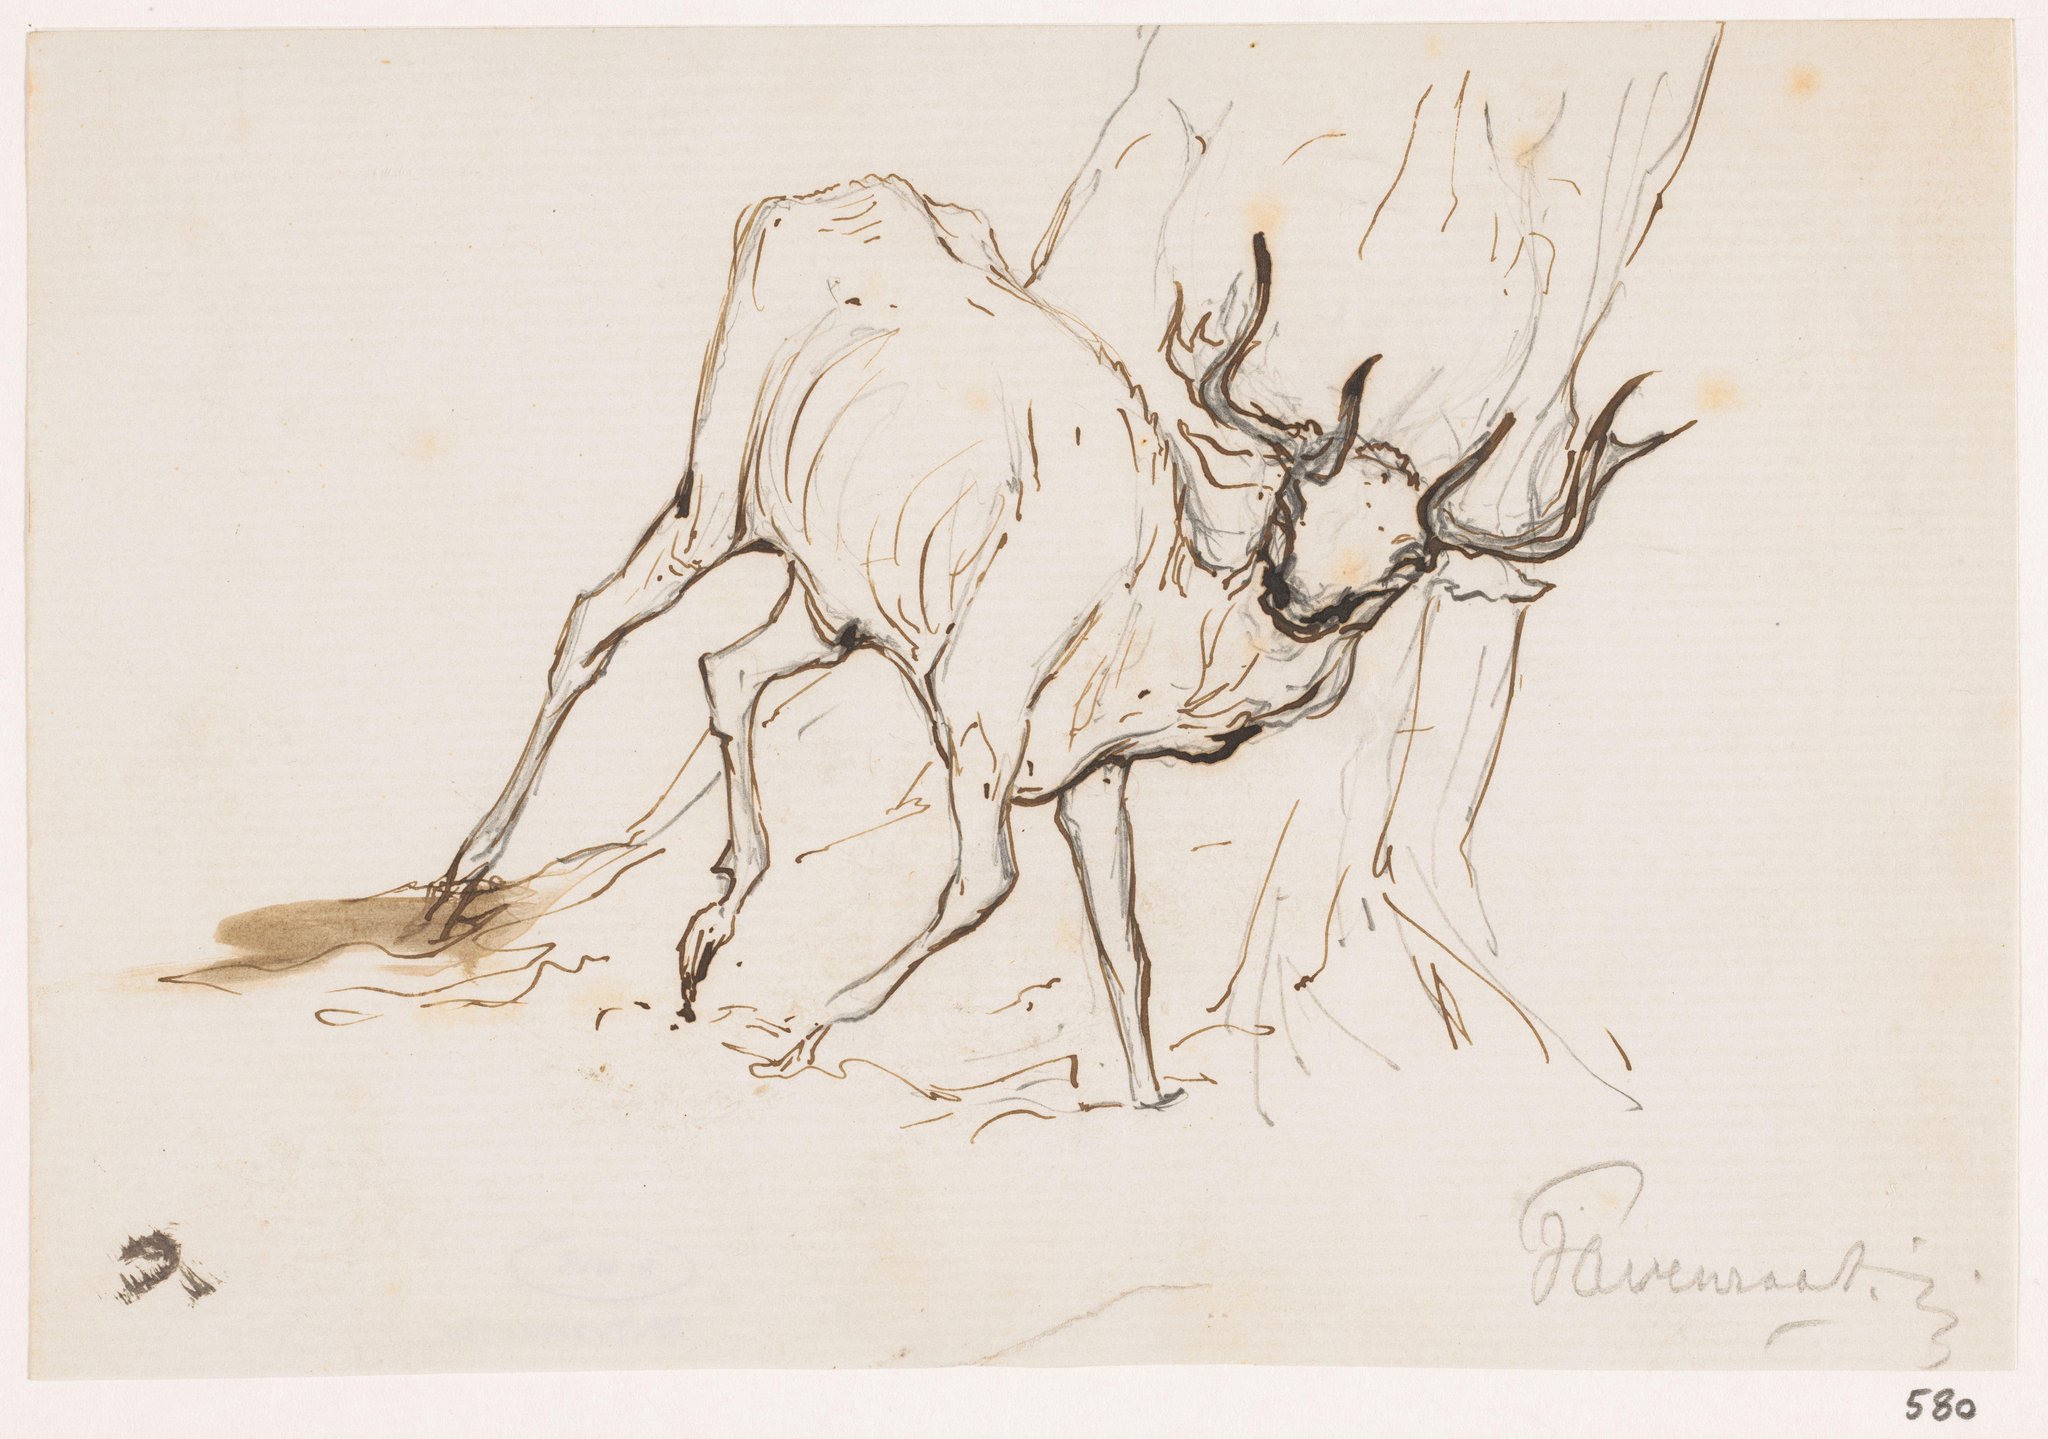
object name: drawing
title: Hert bij een boom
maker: johannes tavenraat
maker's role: draughtsman, painter, print maker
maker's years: 1809-1881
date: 1840-1880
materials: ink, paper, pencil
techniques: pen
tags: hoofed animals: deer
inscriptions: collector's mark: Lugt 2228, signature: ‘Tavenraat’